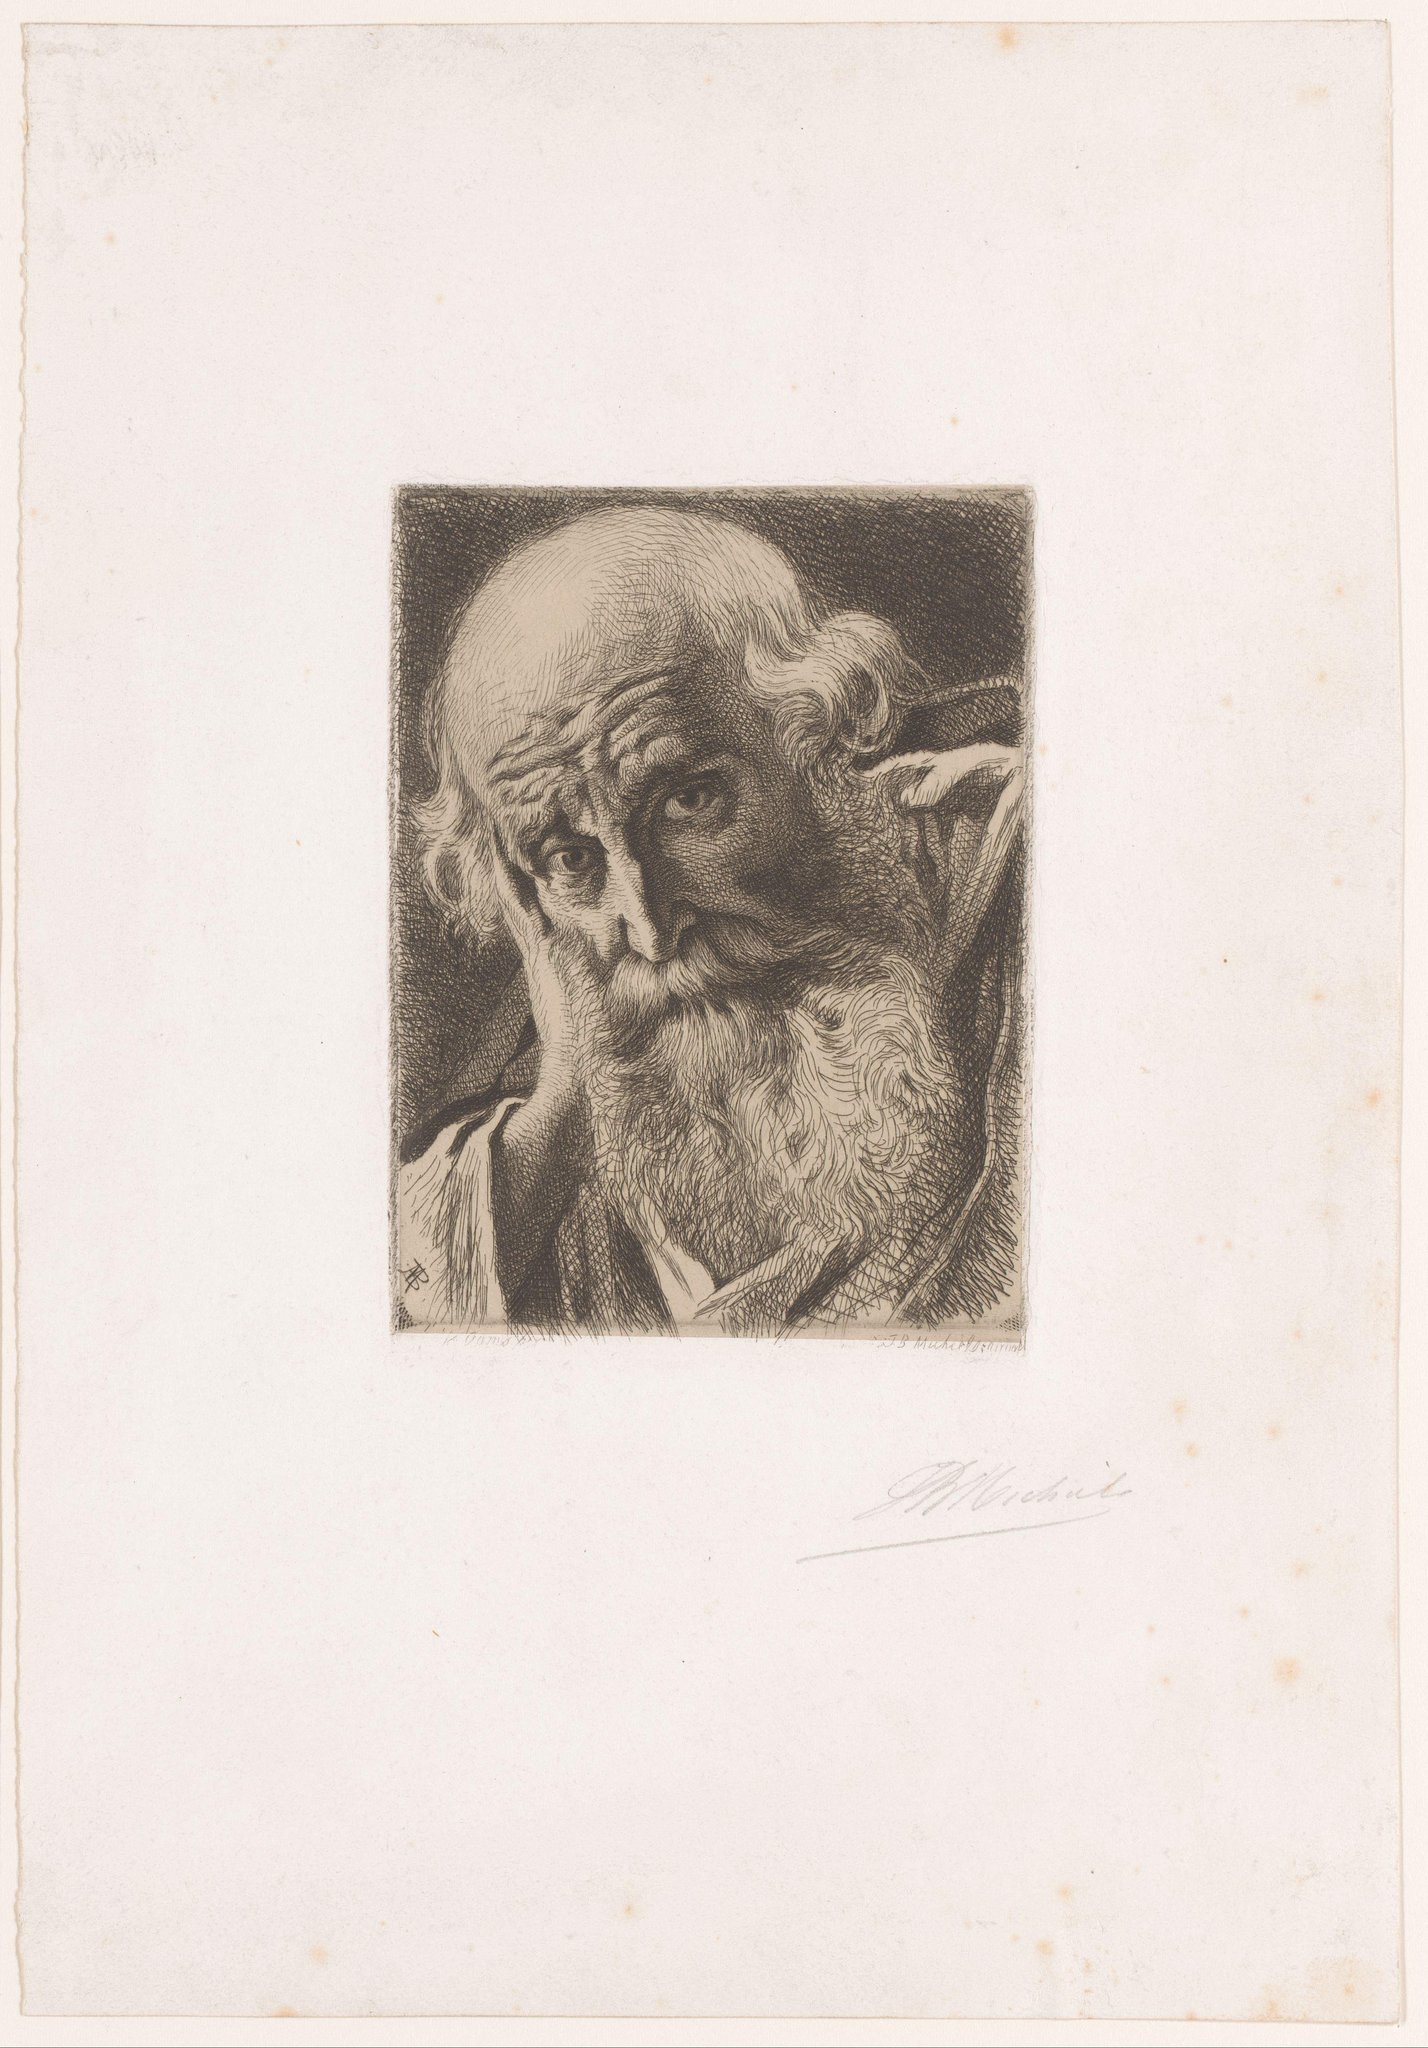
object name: print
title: Hoofd van een oude man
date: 1880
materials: paper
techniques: etching, intaglio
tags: old man, beard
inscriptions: collector's mark: Lugt 2228